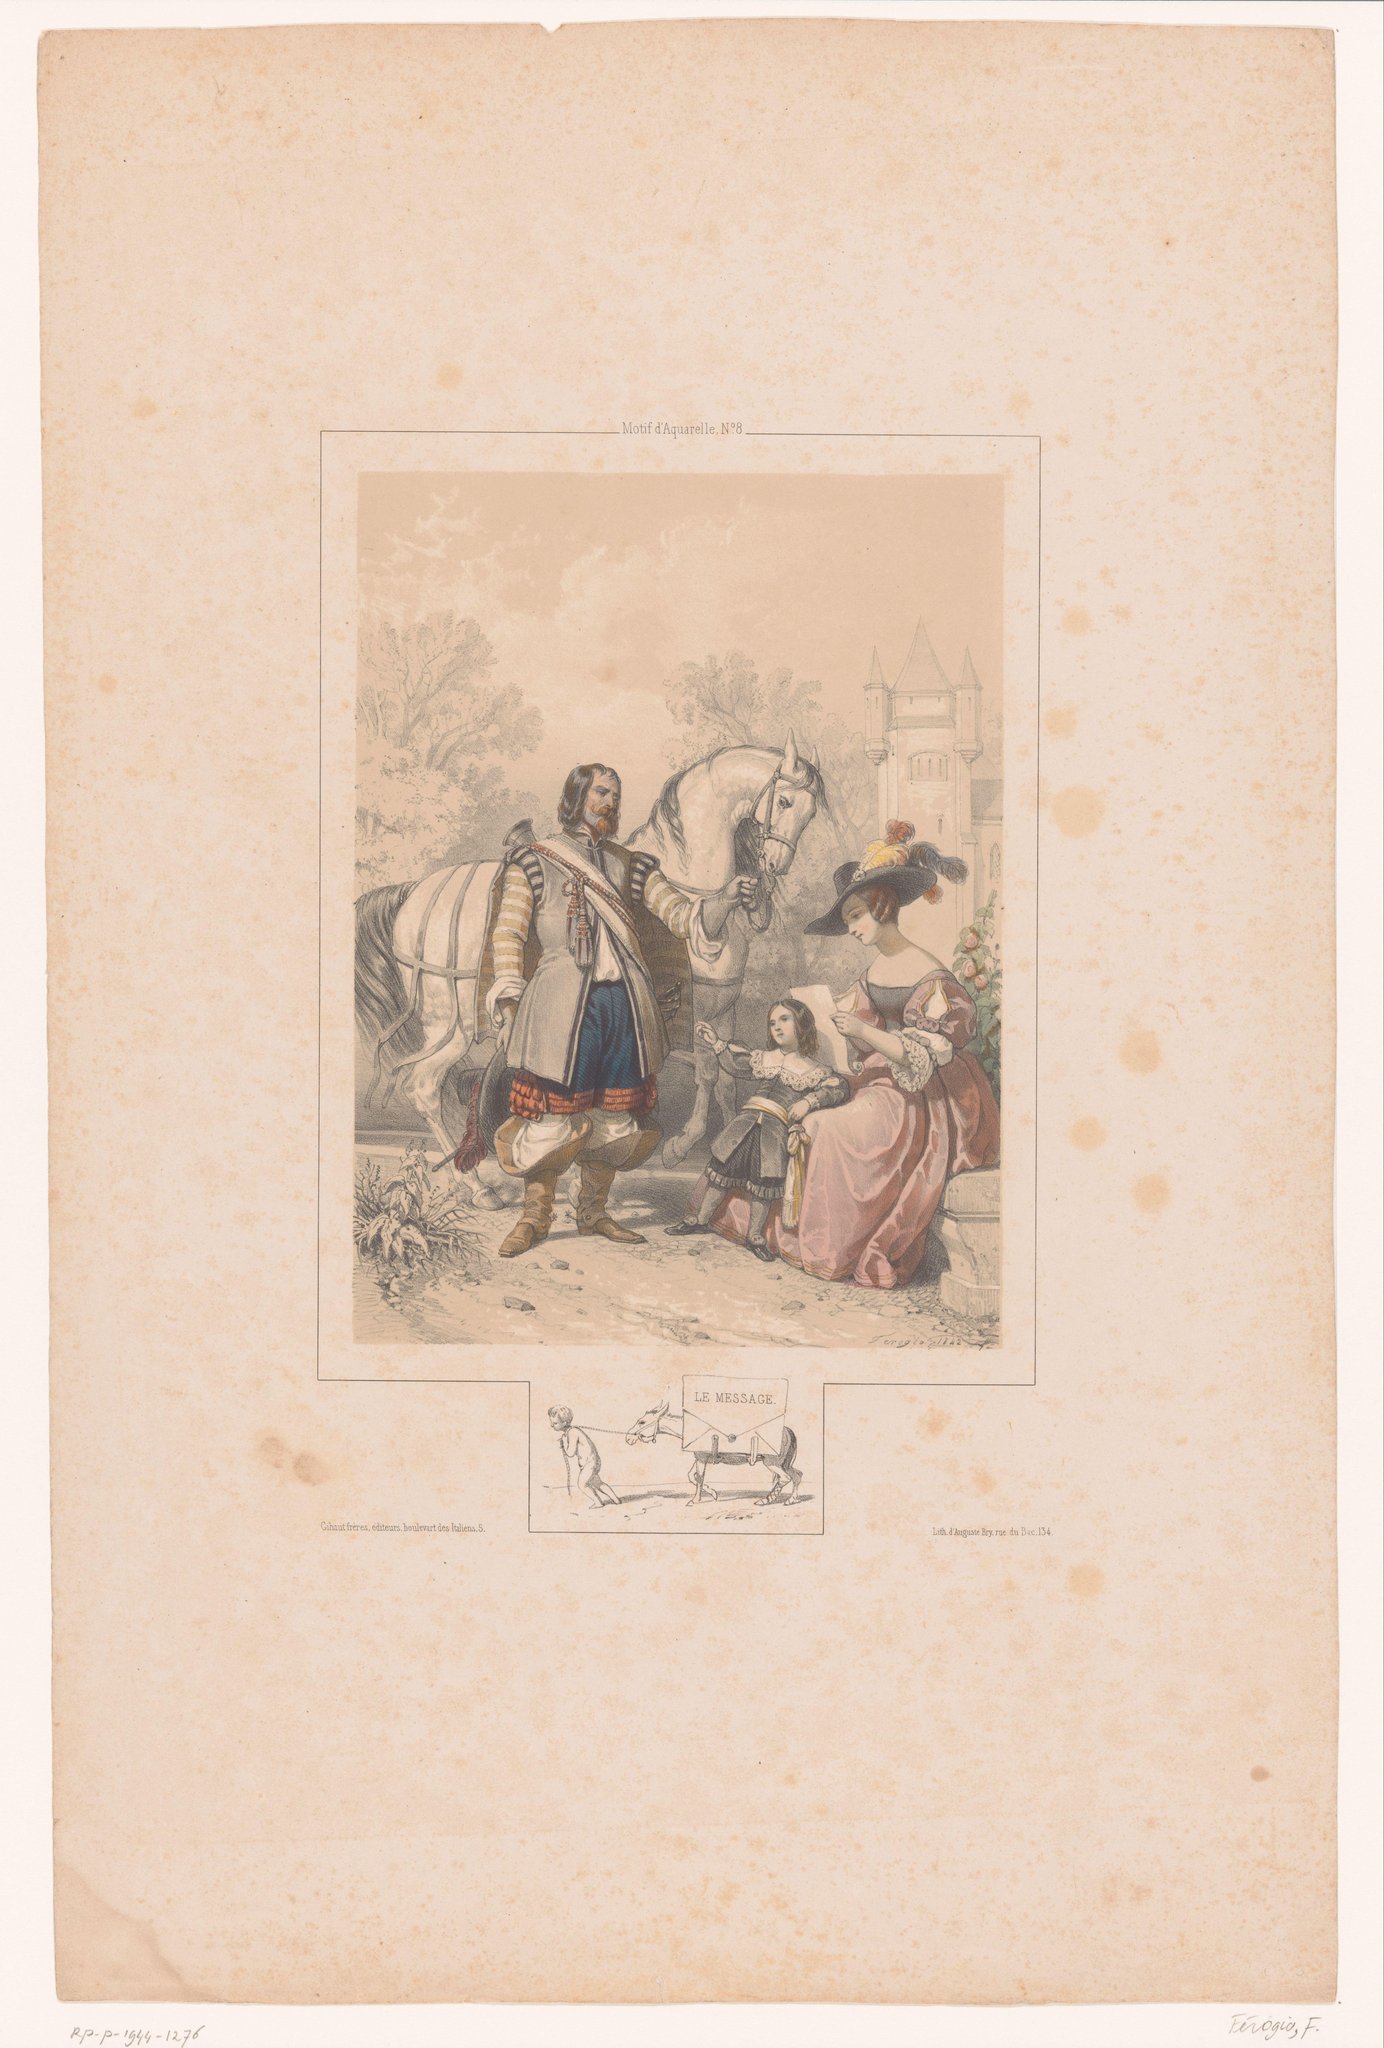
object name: print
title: Motieven voor aquarel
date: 1842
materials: paper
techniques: hand coloring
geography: paris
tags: delivering; receiving (~ postal matter), messenger, letter, envelope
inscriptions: collector's mark: Lugt 2228a